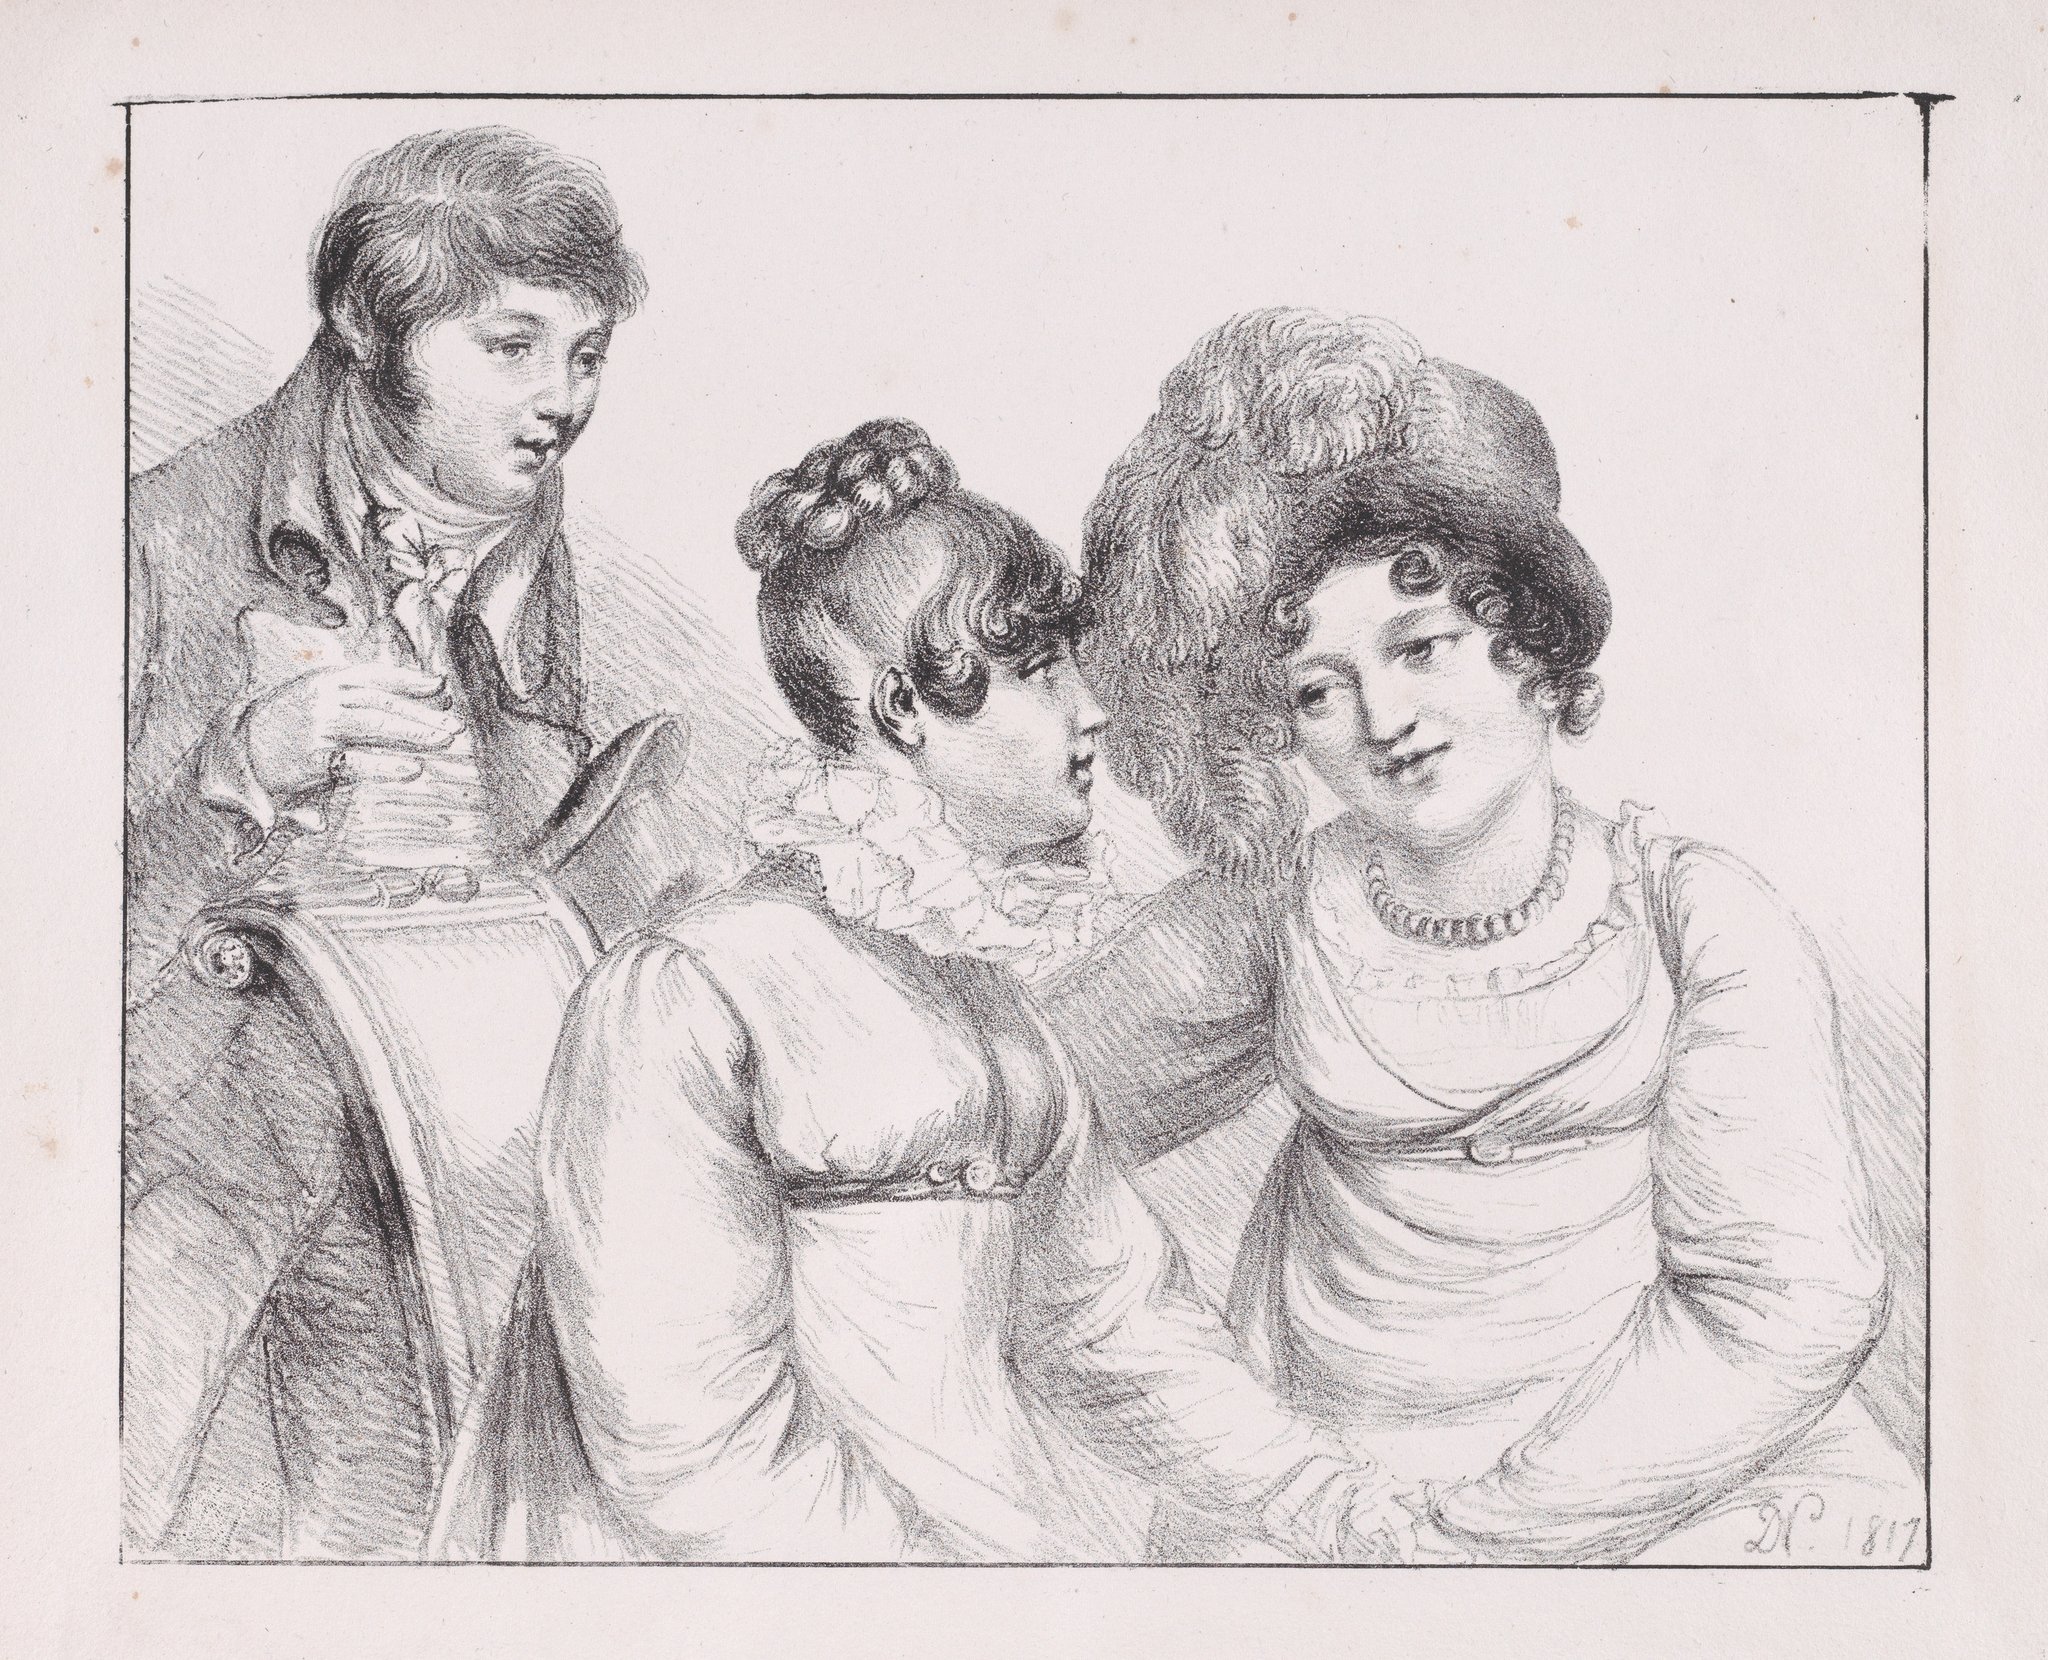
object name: print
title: Group of three figures, man and two women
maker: baron dominique vivant denon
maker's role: artist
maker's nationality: french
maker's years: 1747-1825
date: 1817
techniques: lithograph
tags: men,women